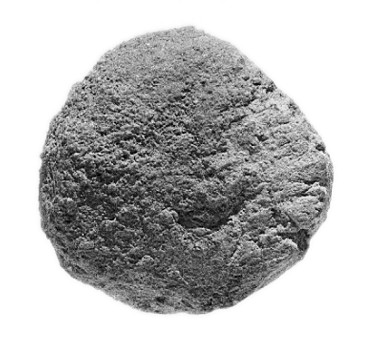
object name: sealing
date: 1981-1640 BCE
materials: mud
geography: egypt